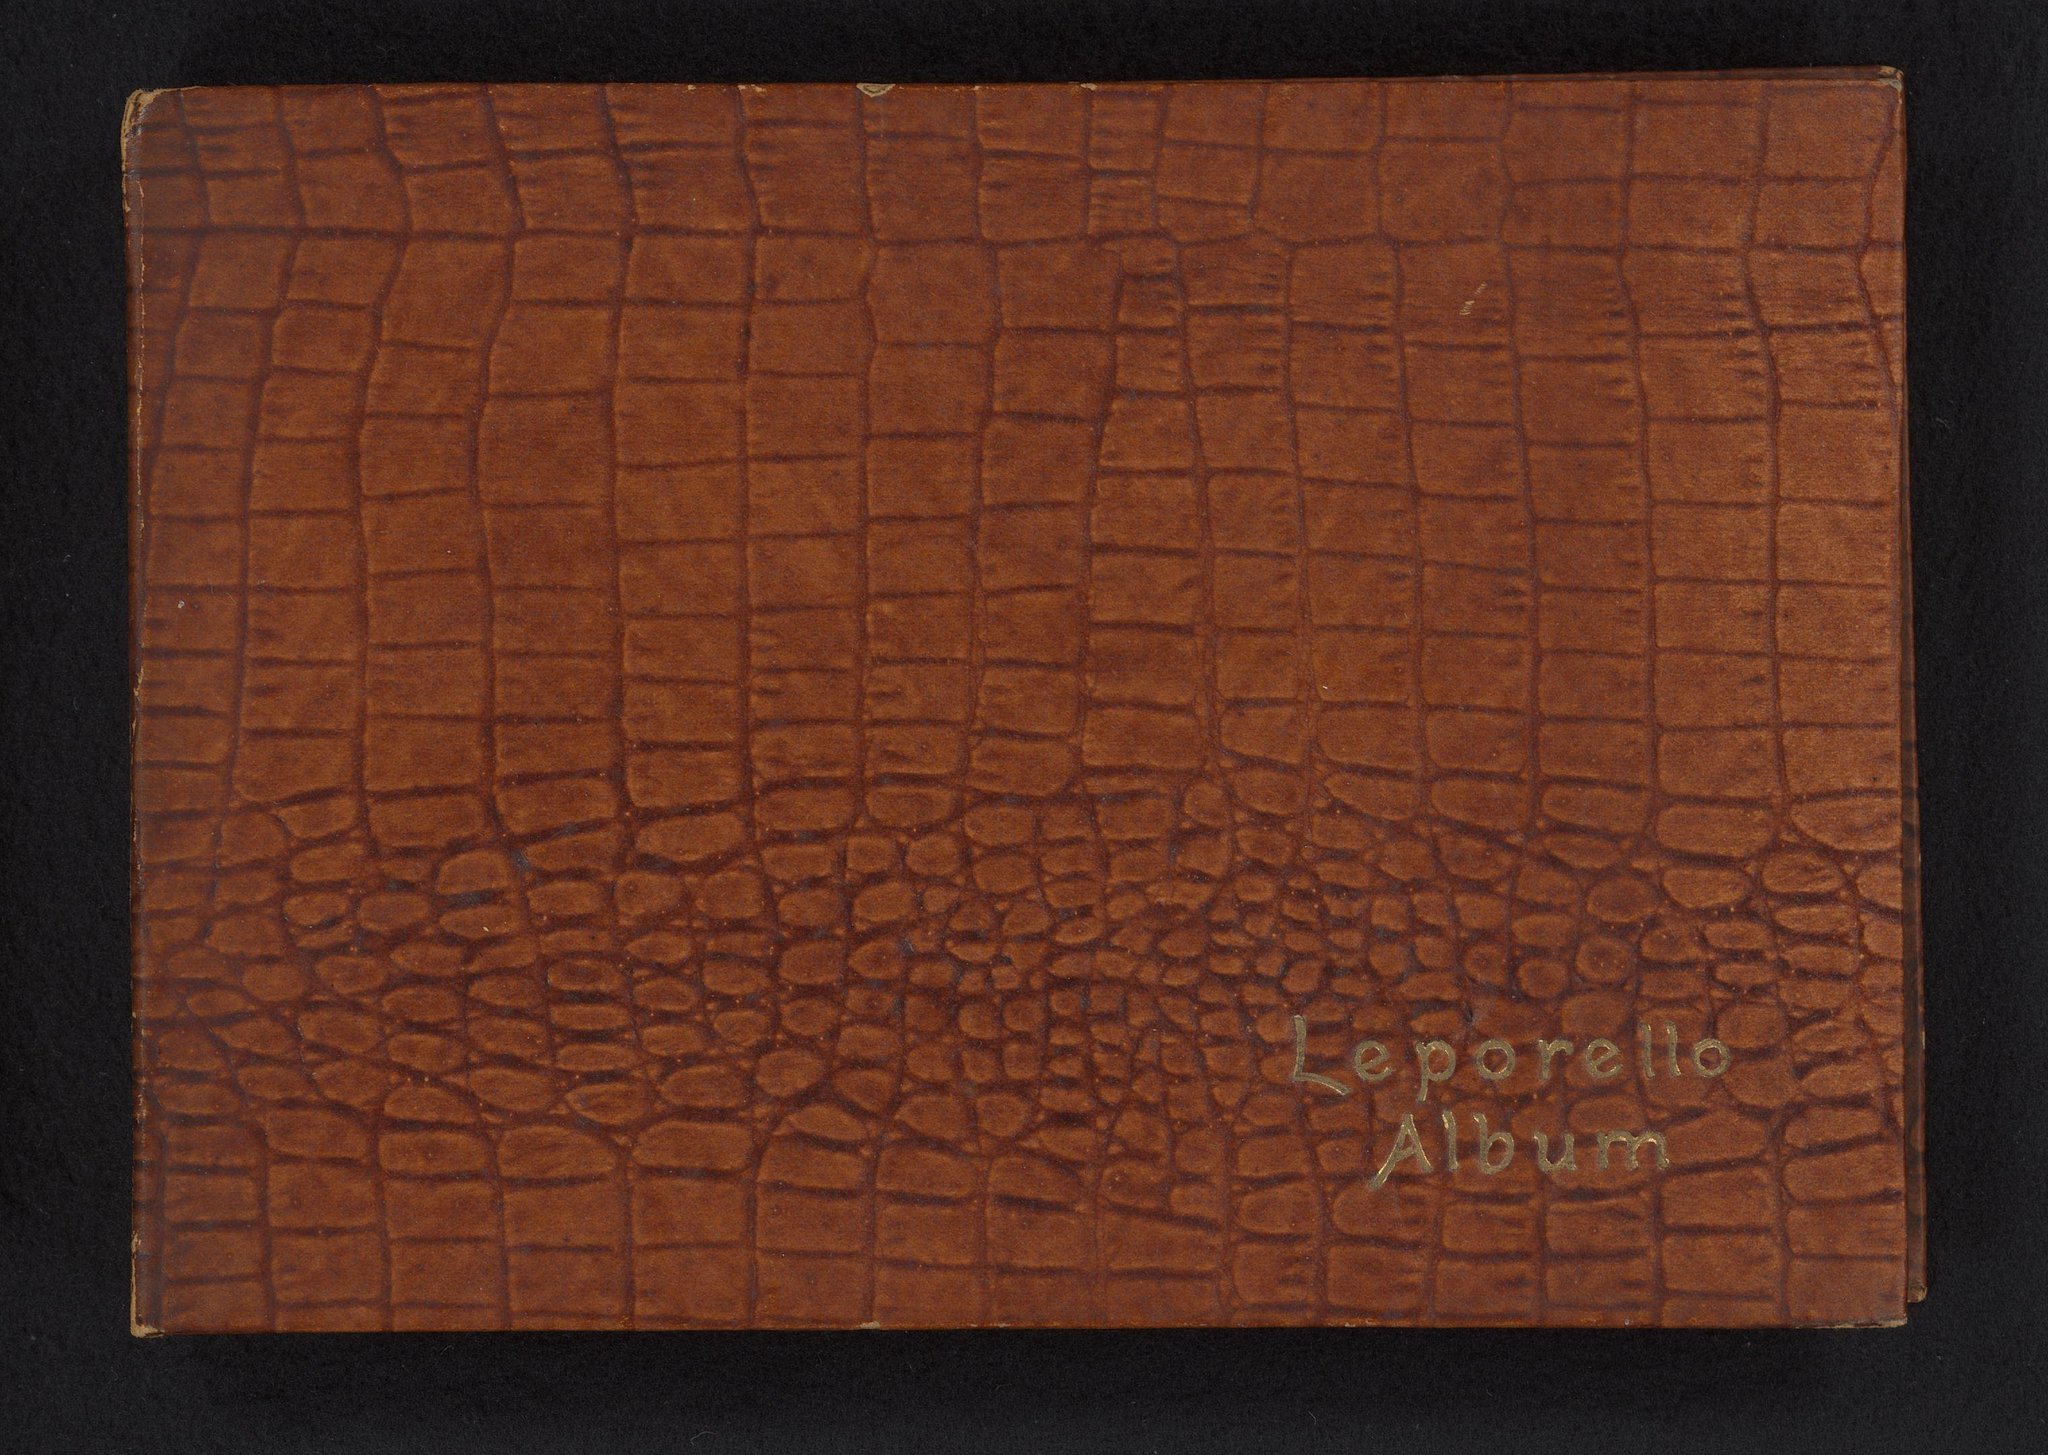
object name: accordion book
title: Leporelloalbum met 12 foto's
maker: Anonymous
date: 1930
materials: cardboard, photographic support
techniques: gelatin silver print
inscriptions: inscription: ‘Dienst Verspreide Rijkskollekties (...)’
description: Album met 12 portretten op een leporello.